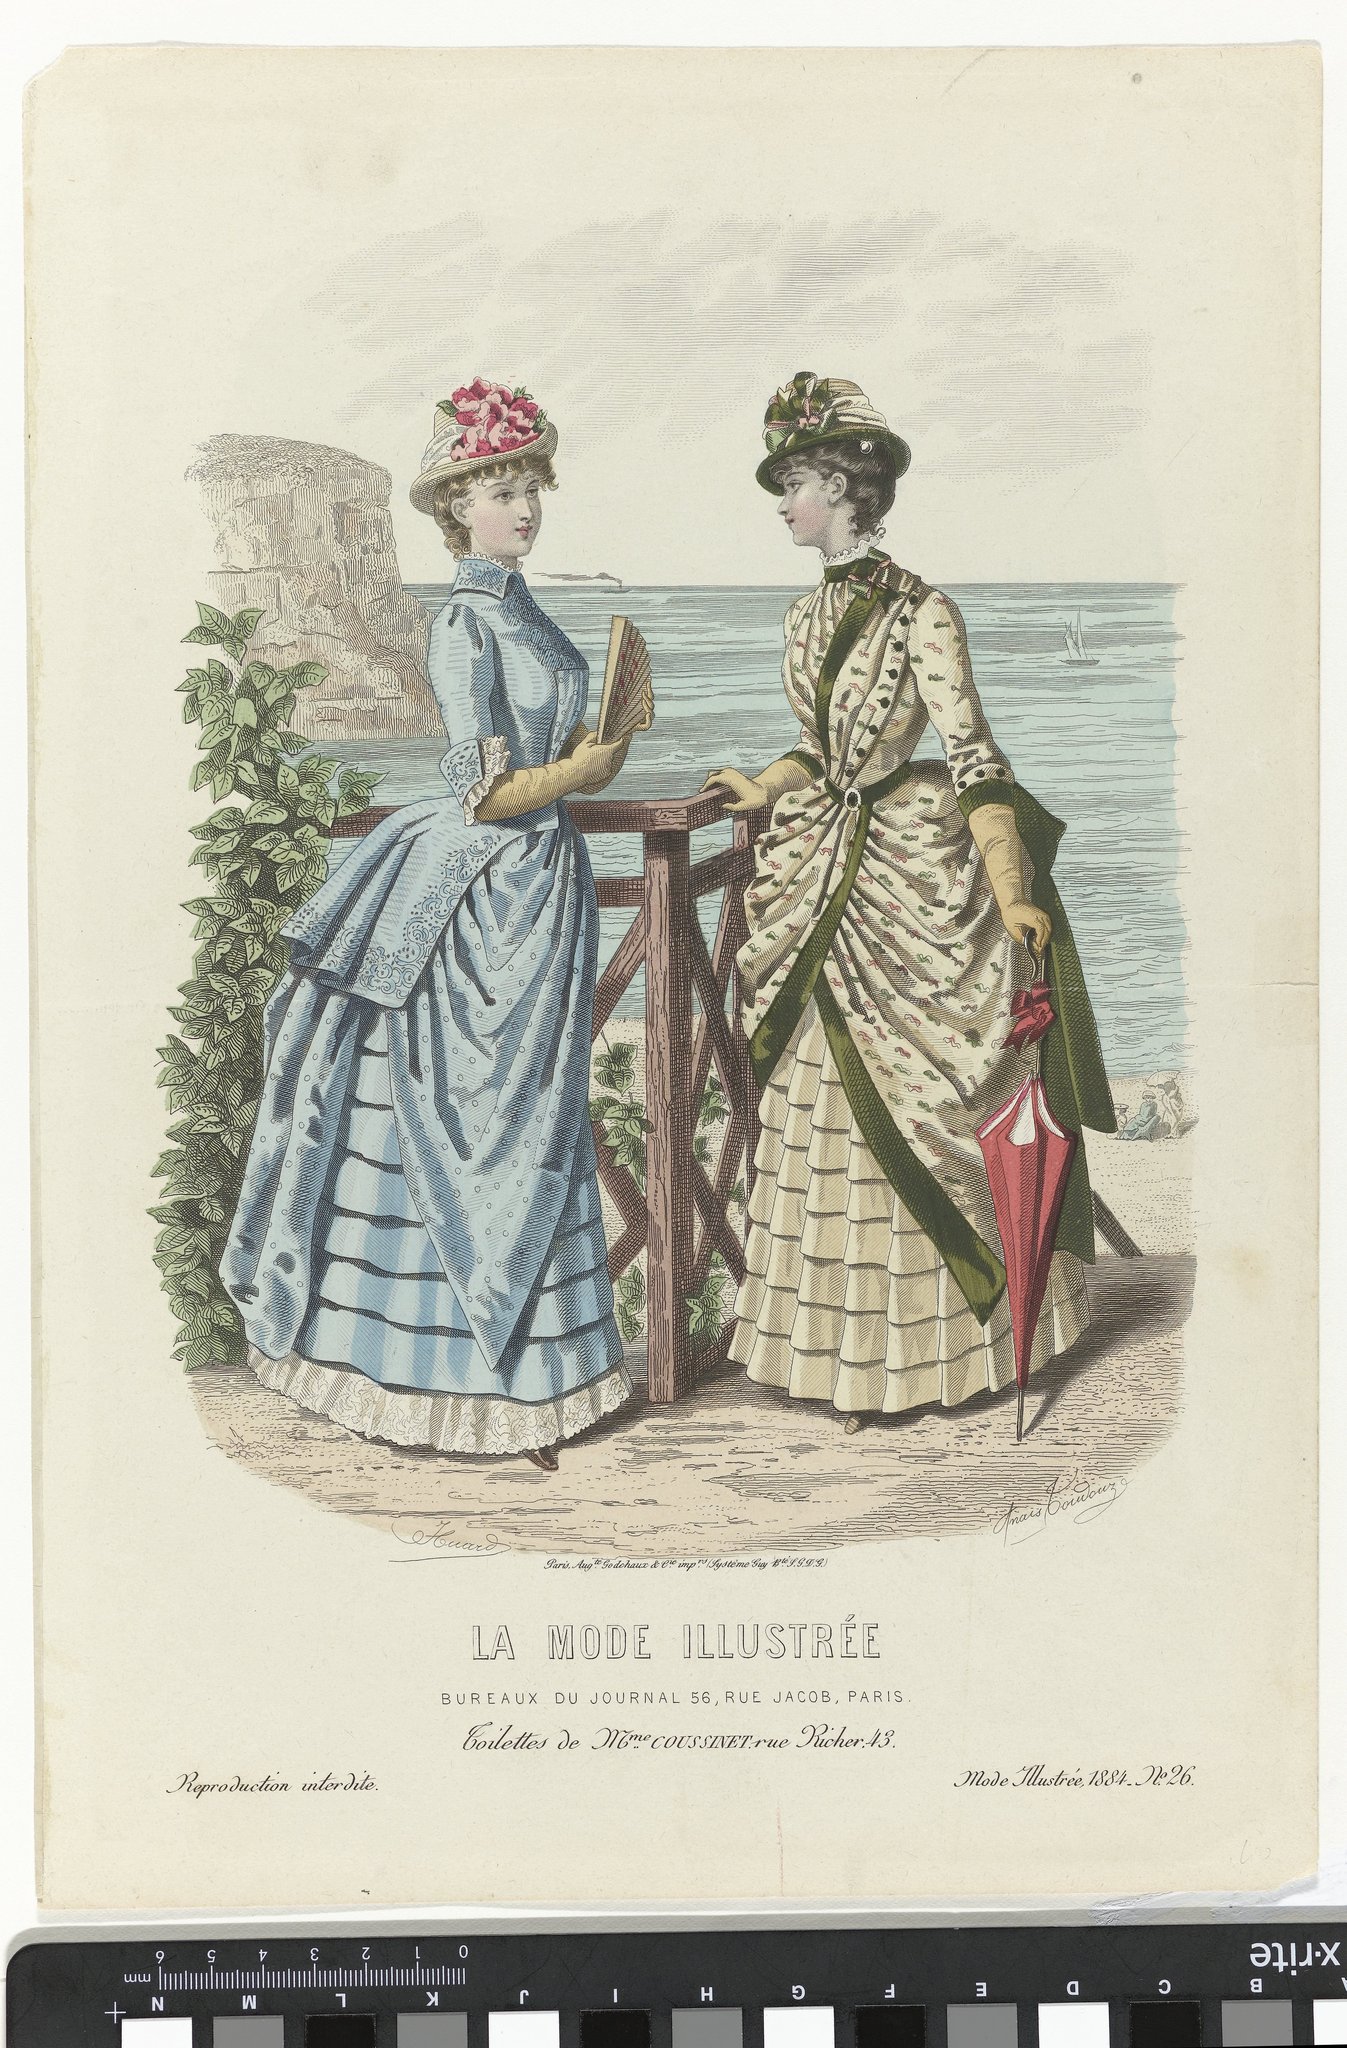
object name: fashion print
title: La Mode Illustrée, 1884, No. 26 : Toilettes de Mme Coussinet (...)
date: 1884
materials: paper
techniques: engraving, hand coloring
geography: paris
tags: beach (as place of recreation), fashion plates, head-gear: hat (+ women's clothes), gloves, mittens, etc. (+ women's clothes), dress, gown (+ women's clothes), sea (seascape), fan (+ women's clothes), parasol, sunshade (+ women's clothes)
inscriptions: address: ‘Bureaux du journal 56, rue Jacob, Paris’, title: ‘La Mode Illustrée’, caption: ‘Toilettes de M.me Coussinet. rue Richer. 43.’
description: Twee vrouwen bij een balustrade, op de achtergrond de zee en het strand. Volgens het onderschrift: ensembles van Coussinet. Prent uit het modetijdschrift La Mode Illustrée (1860-1937).